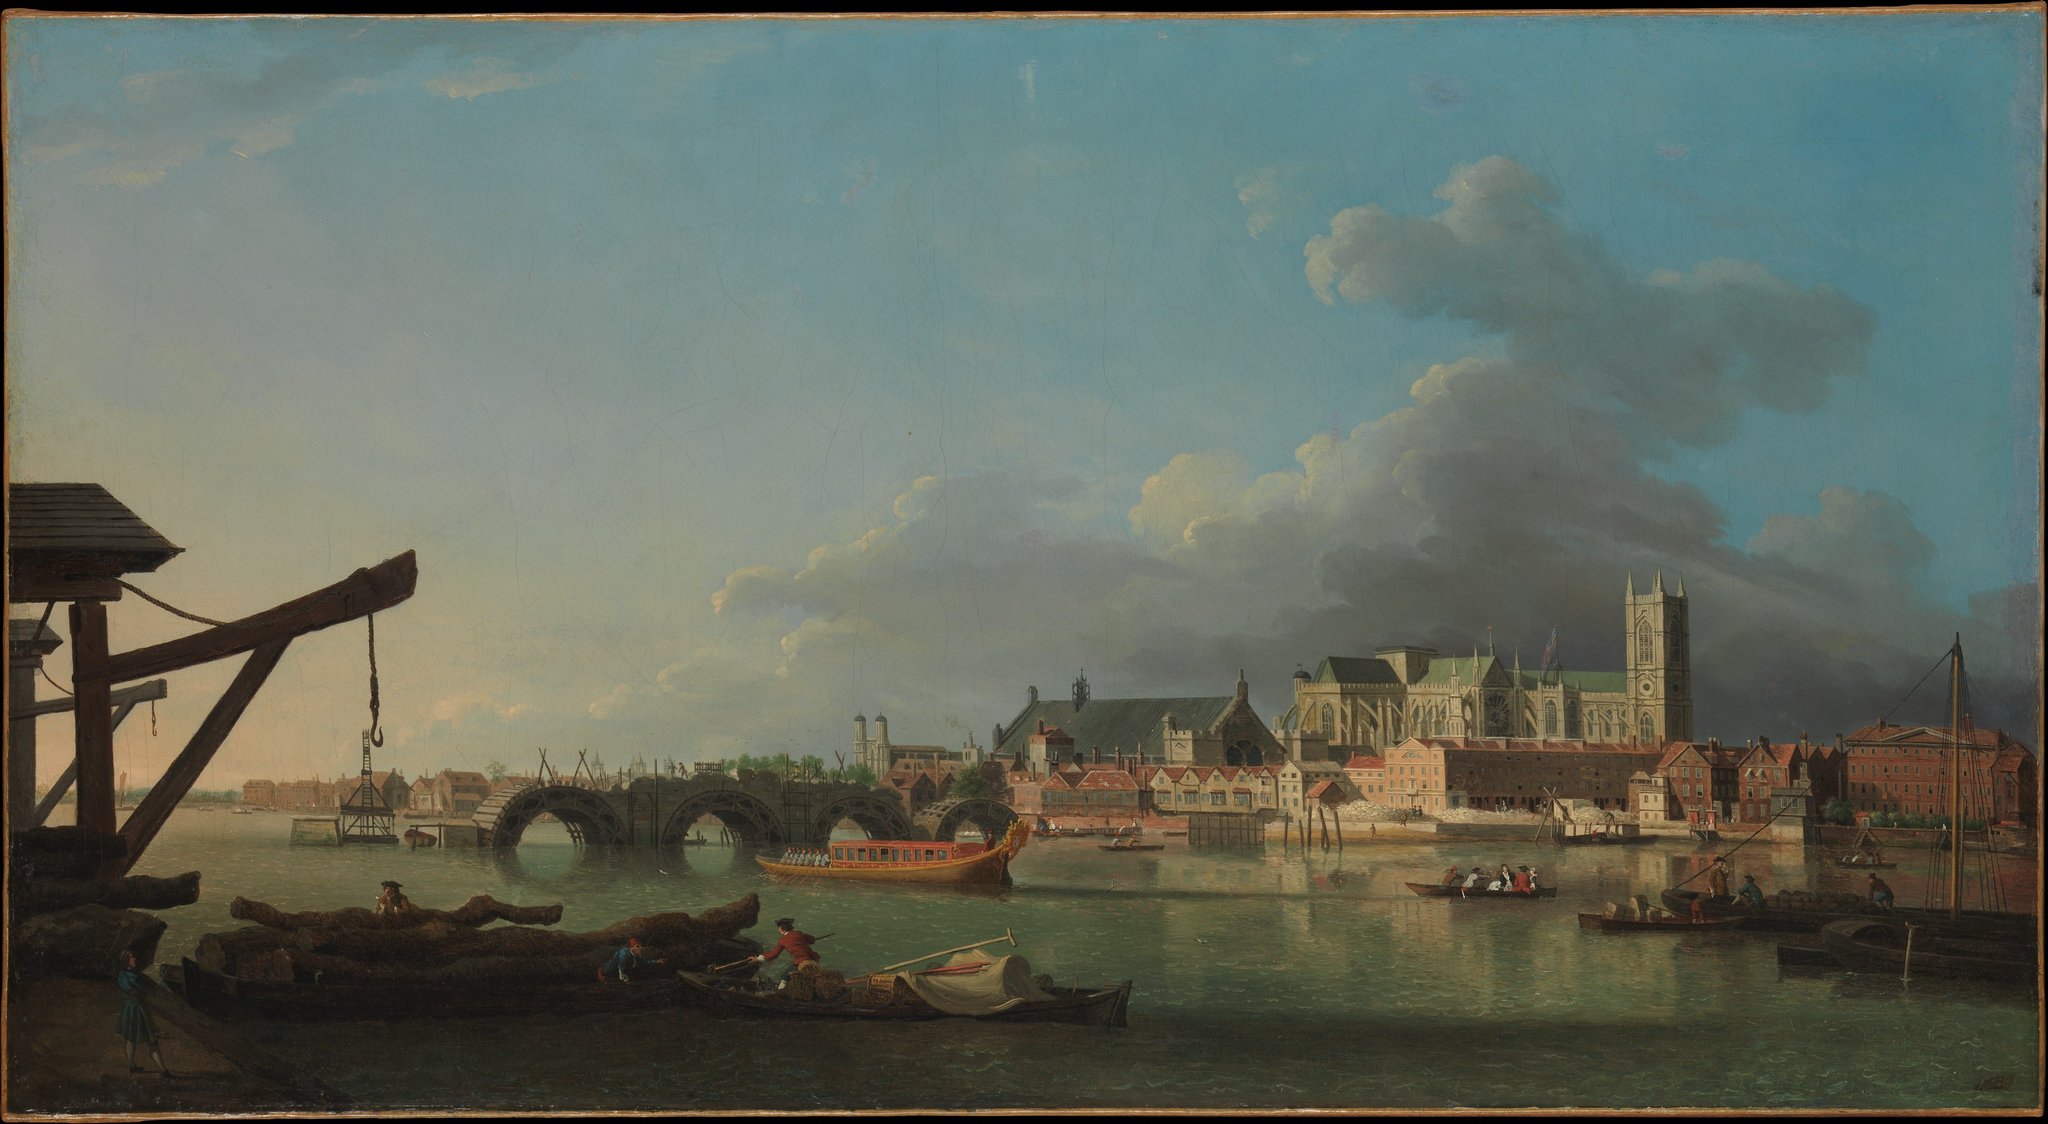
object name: painting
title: The Building of Westminster Bridge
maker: samuel scott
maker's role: artist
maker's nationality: british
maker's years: 1697-1772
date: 1722-1772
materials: canvas, oil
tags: buildings,bridges,cathedrals,rivers,boats,london